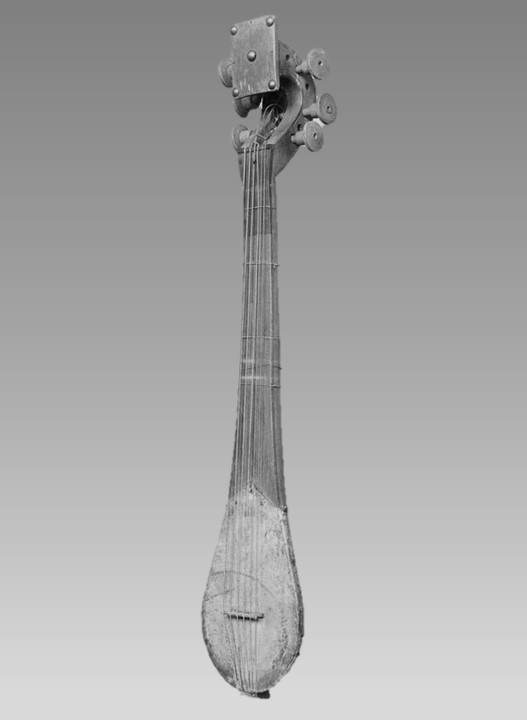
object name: stringed instrument qanbus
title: Stringed Instrument (Qanbus)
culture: arabian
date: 1867-1900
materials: wood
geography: arabia